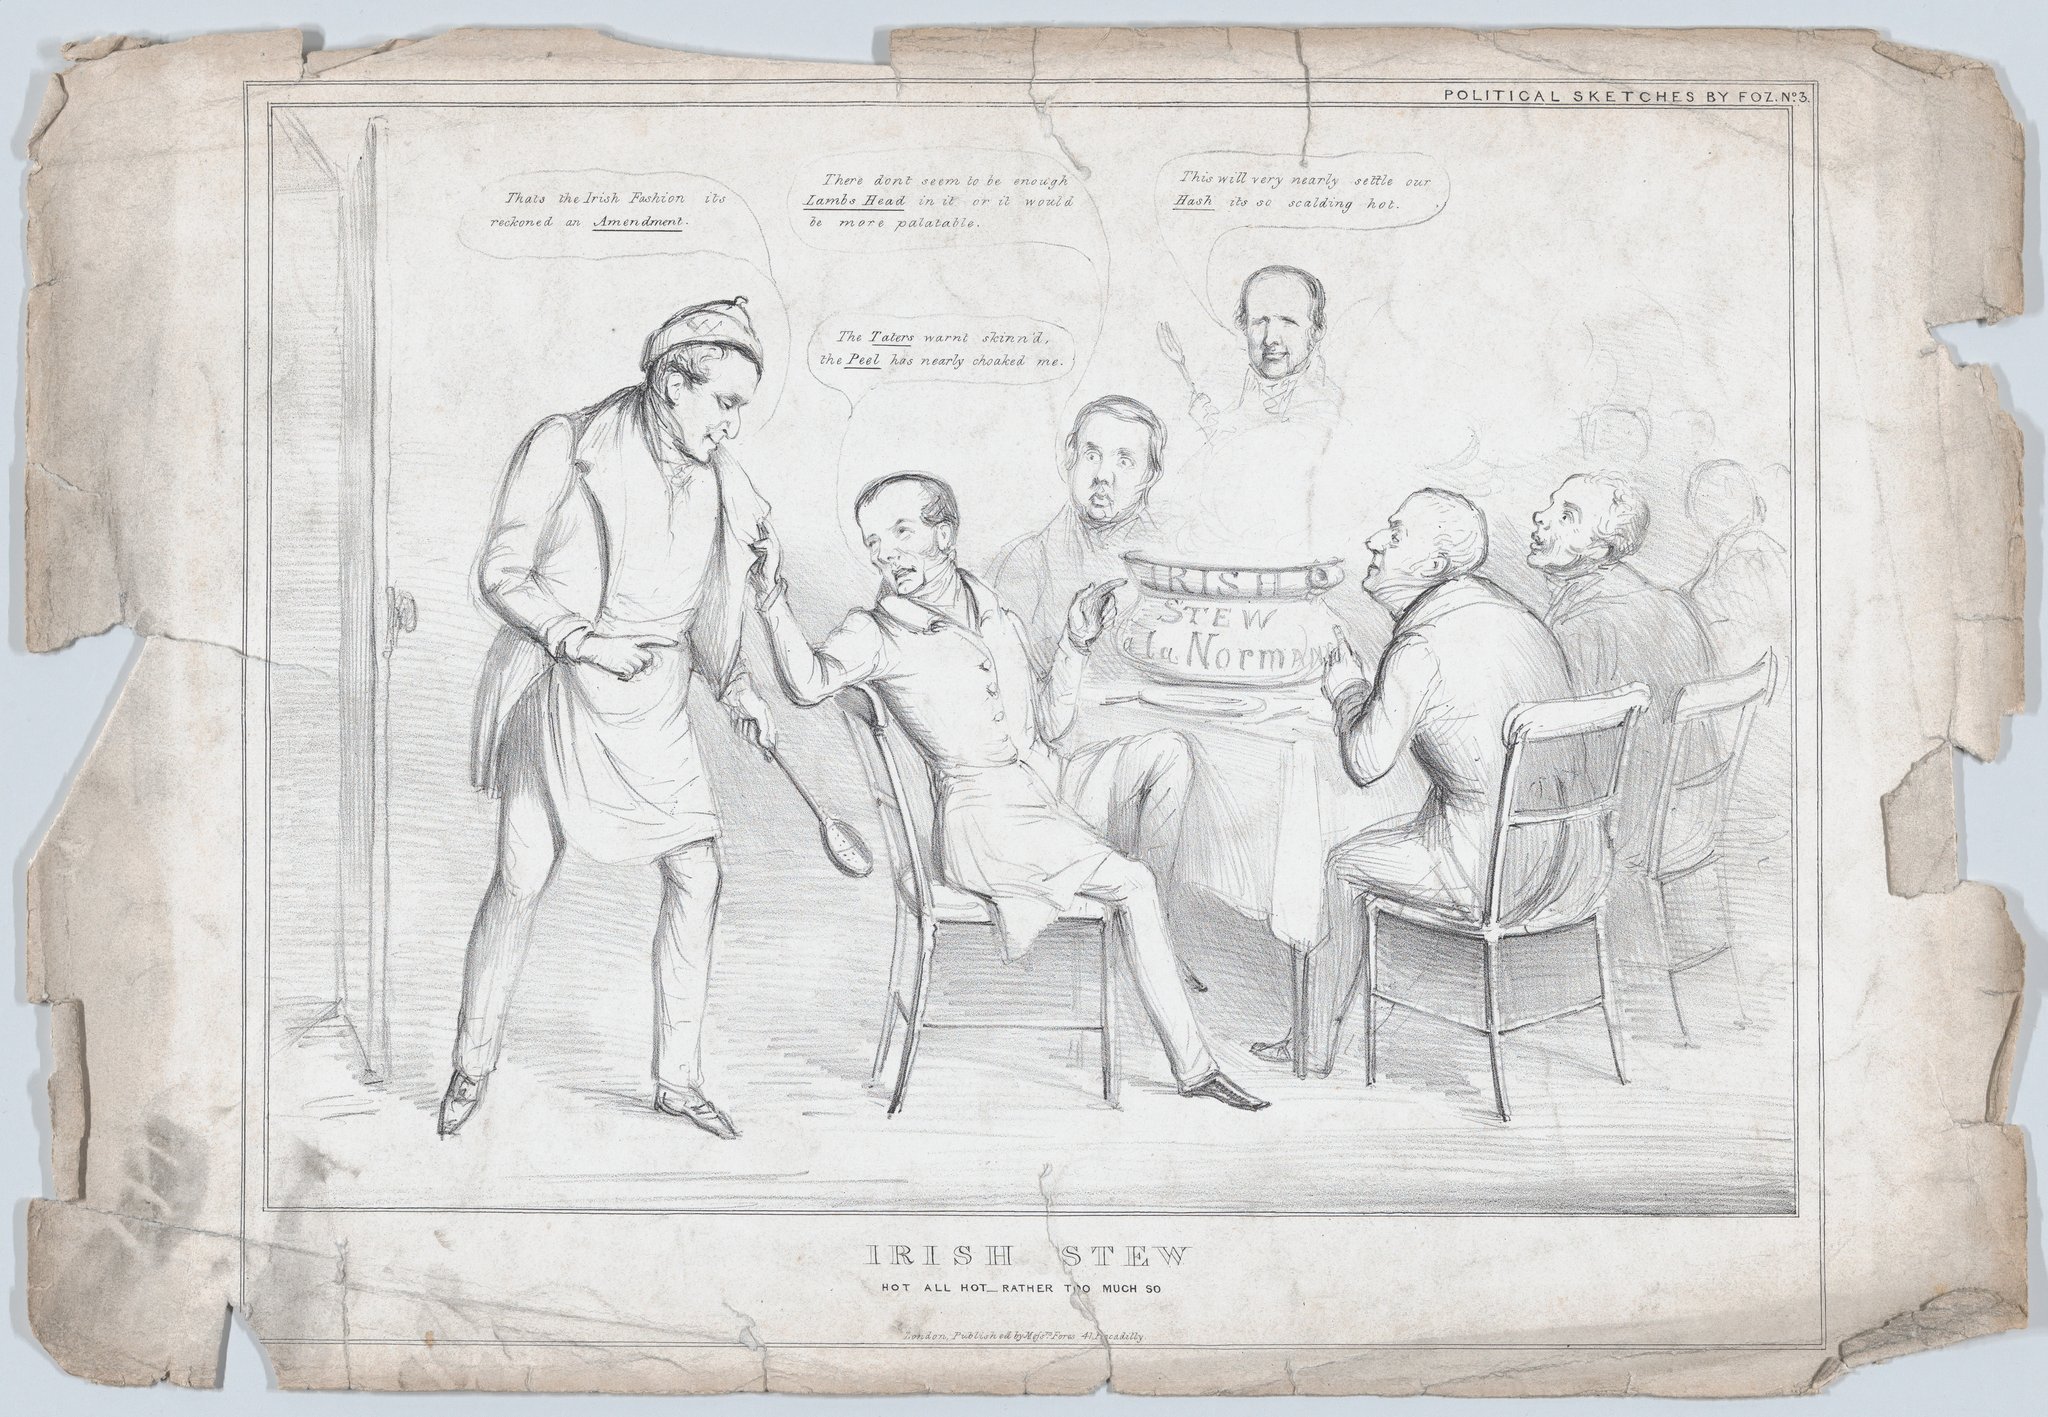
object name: print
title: Irish Stew: Not All Hot – Rather Too Much So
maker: mssrs. fores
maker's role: publisher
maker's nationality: british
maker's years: 1761-1999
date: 1840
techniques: lithograph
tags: food,men